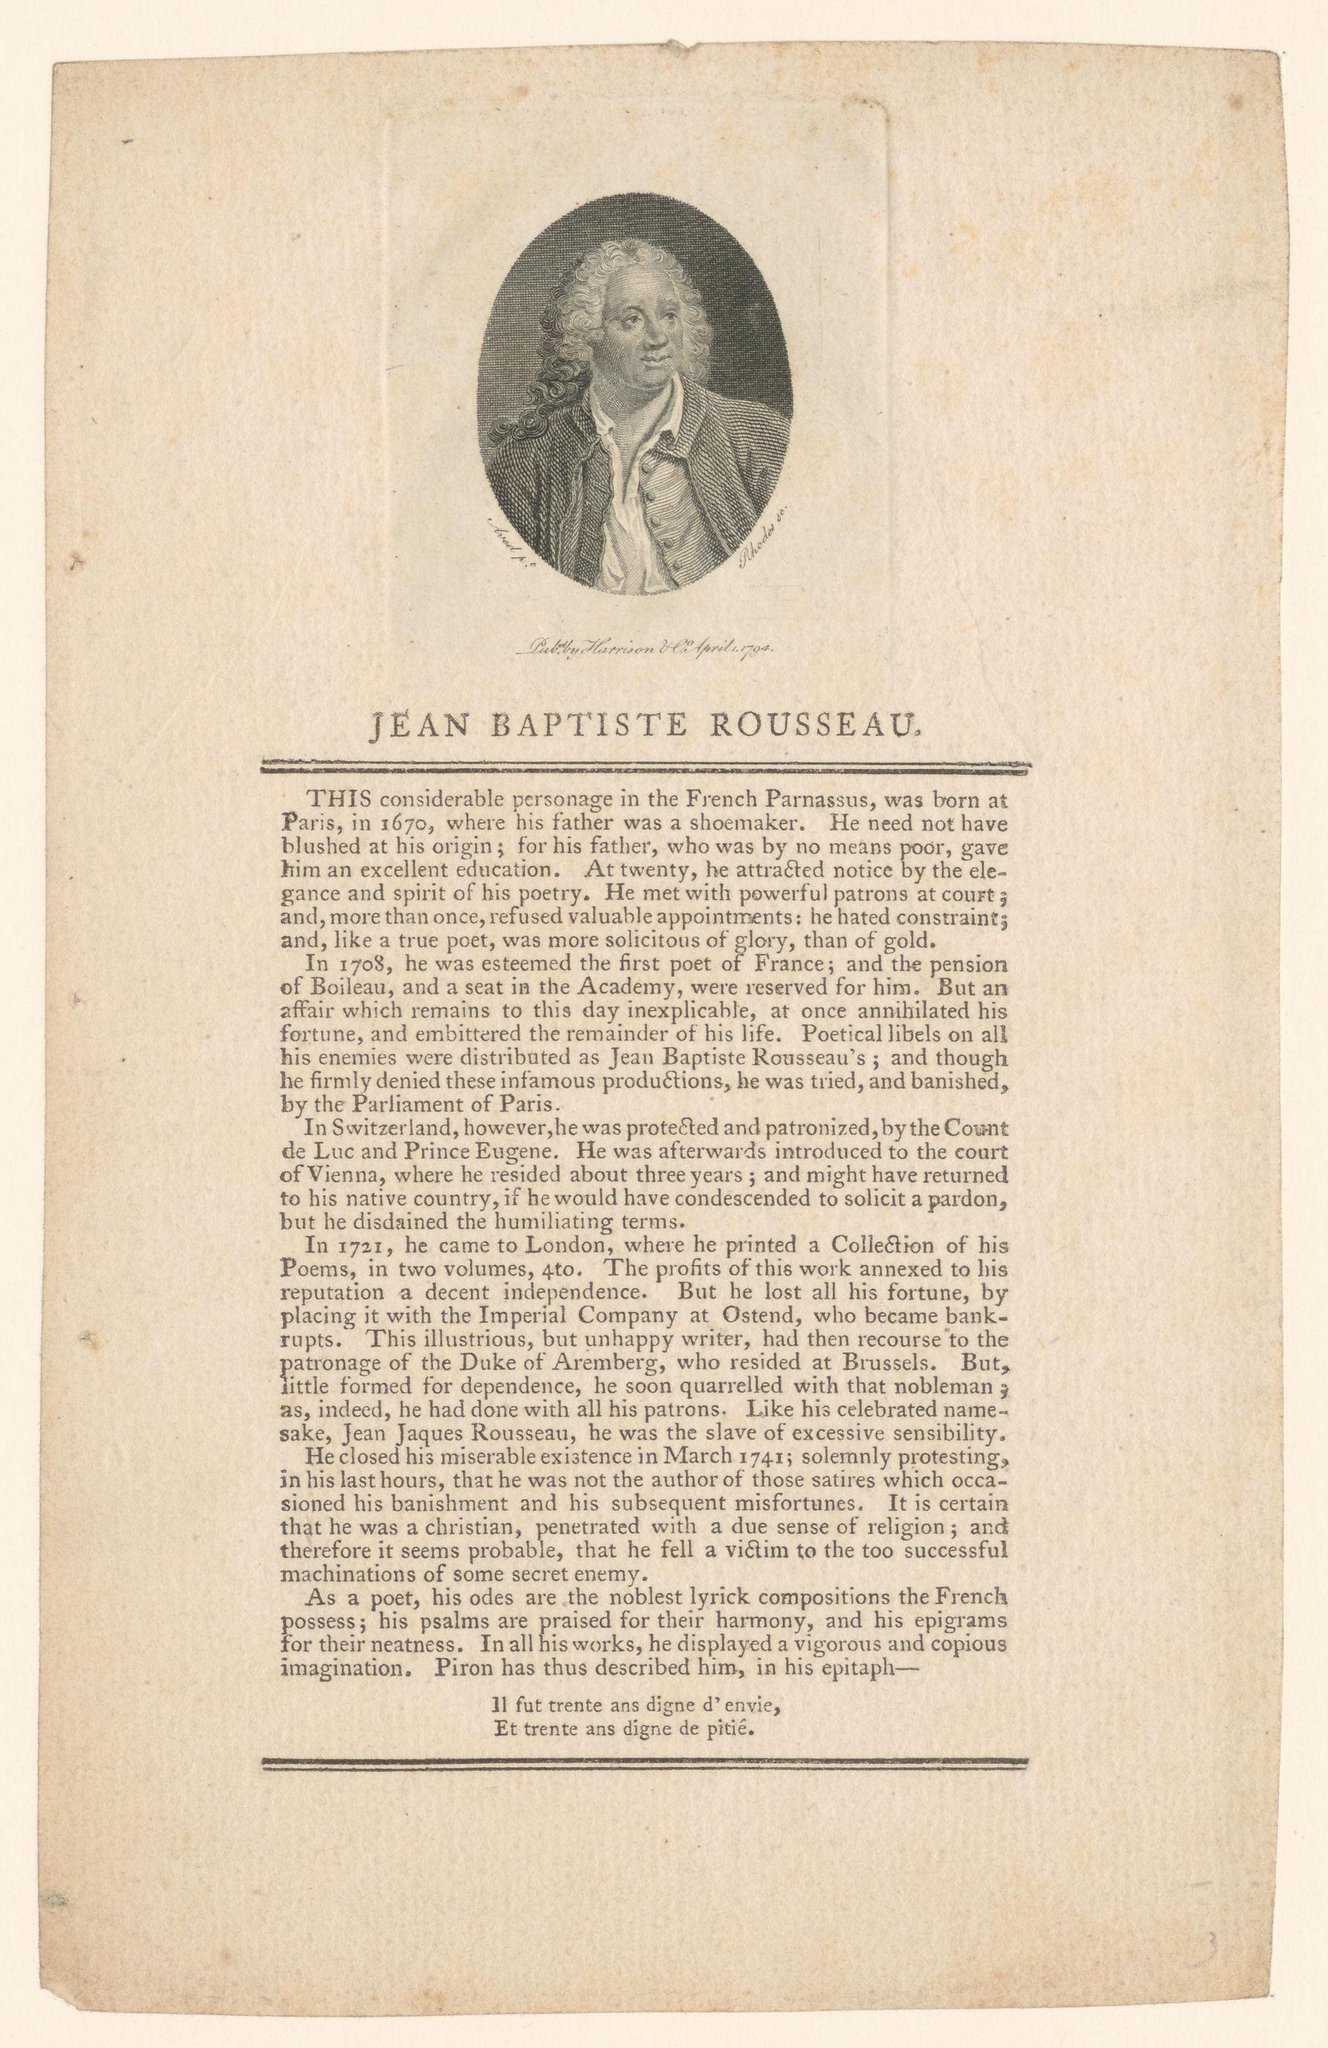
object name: print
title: Portret van Jean-Baptiste Rousseau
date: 1794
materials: paper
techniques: engraving, letterpress printing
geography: london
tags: paris, brussels, jean baptiste rousseau (1669-1741), director, producer ~ the stage, historical persons, portrait of a writer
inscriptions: collector's mark: Lugt 2228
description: Prent gebruikt in: The Biographical Magazine: Containing Portraits & Characters of Eminent (...). Londen: Harrison & Co., 1794.